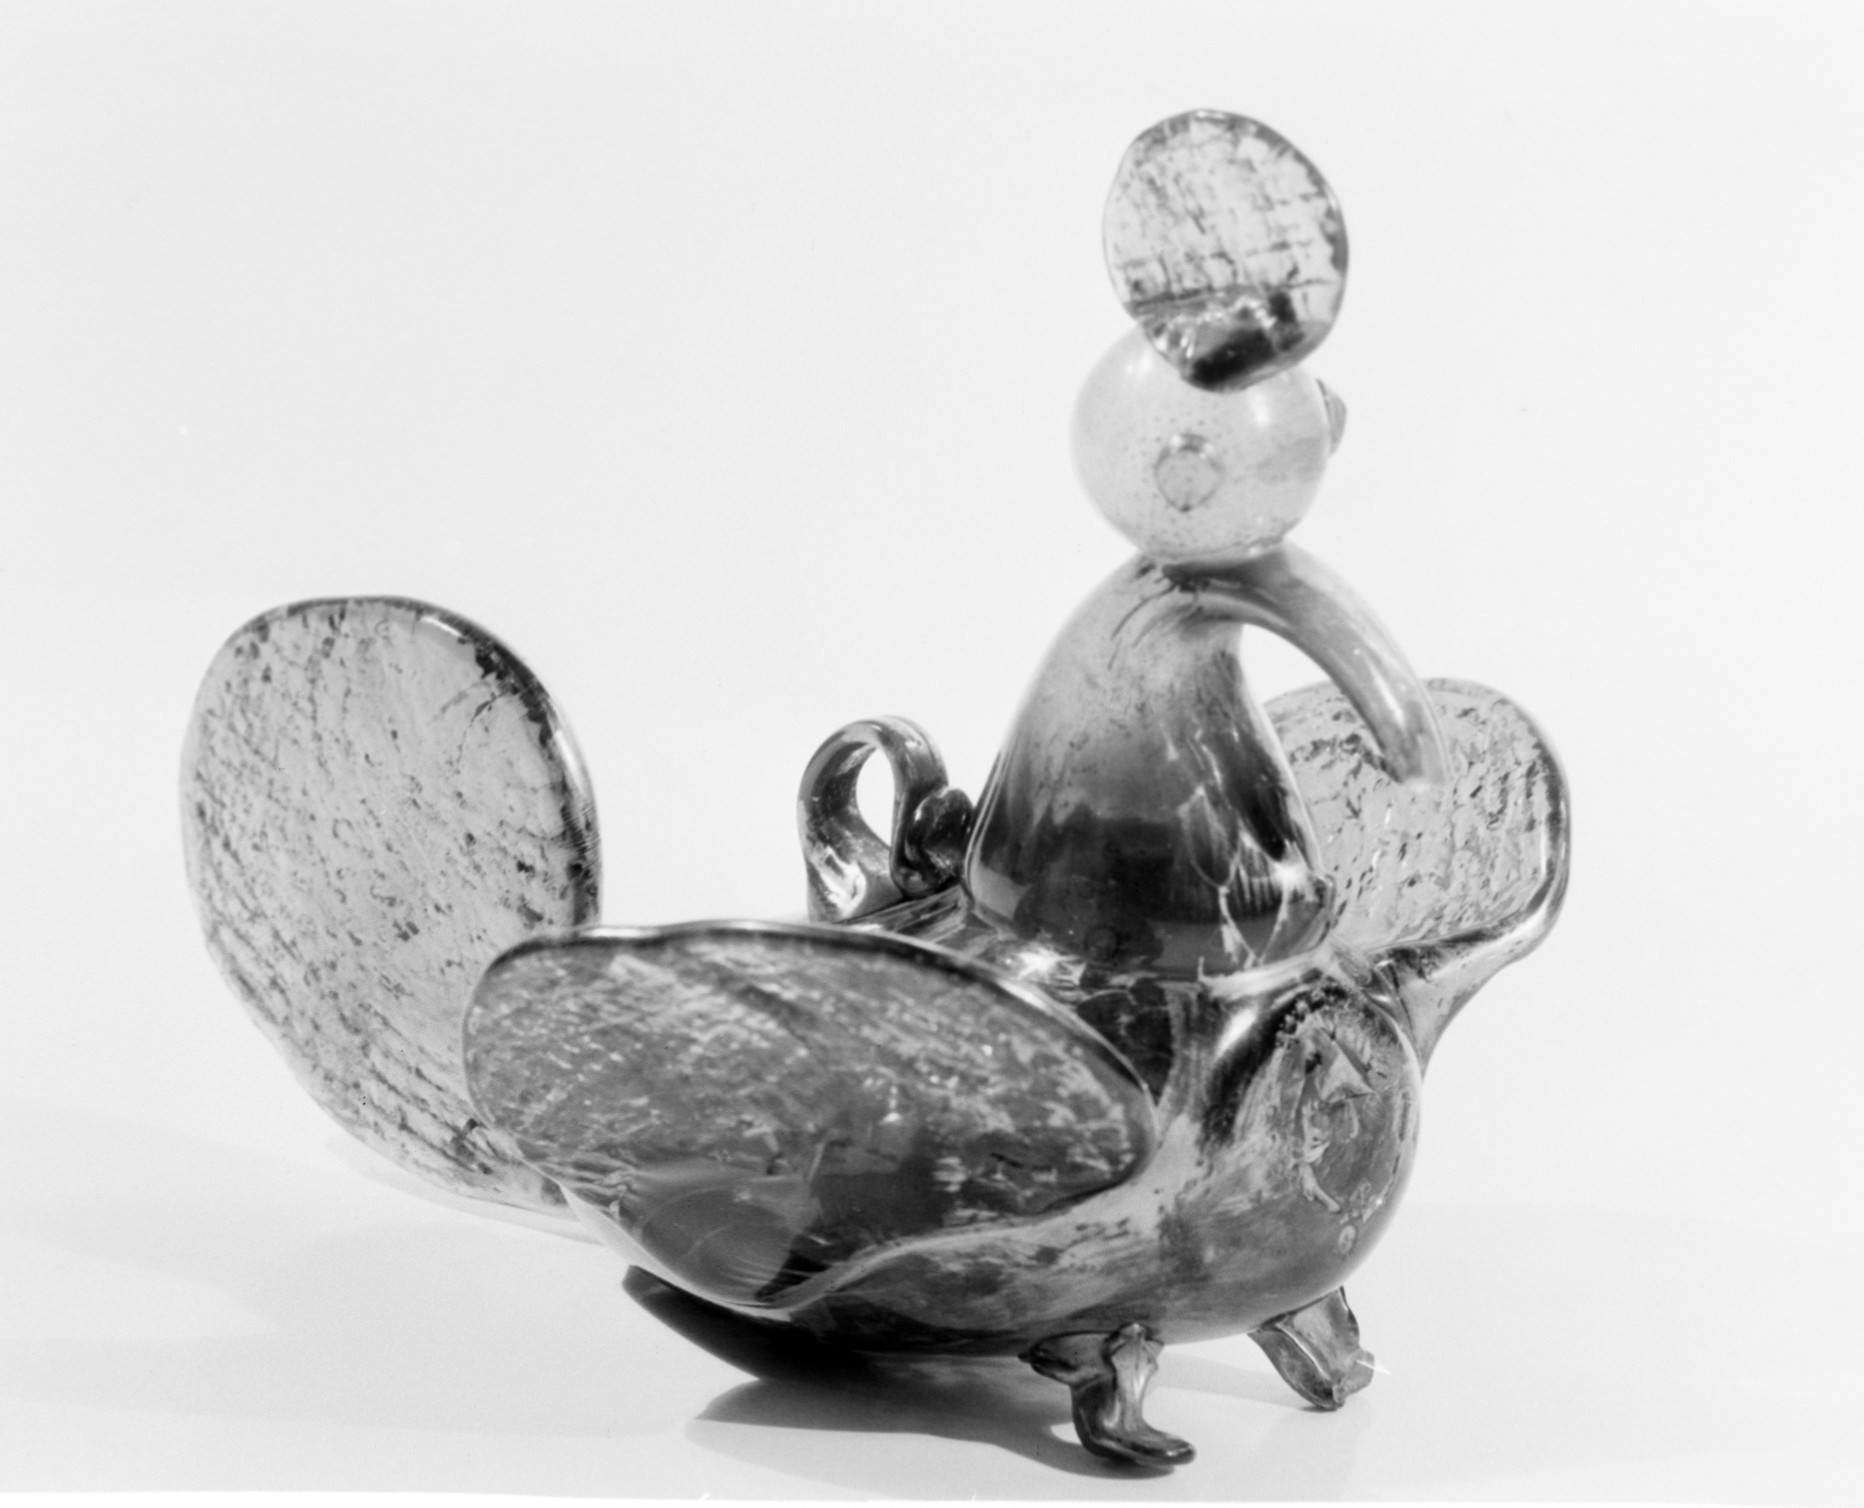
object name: ornament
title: Ornament in the form of a bird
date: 1801-1900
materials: glass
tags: birds